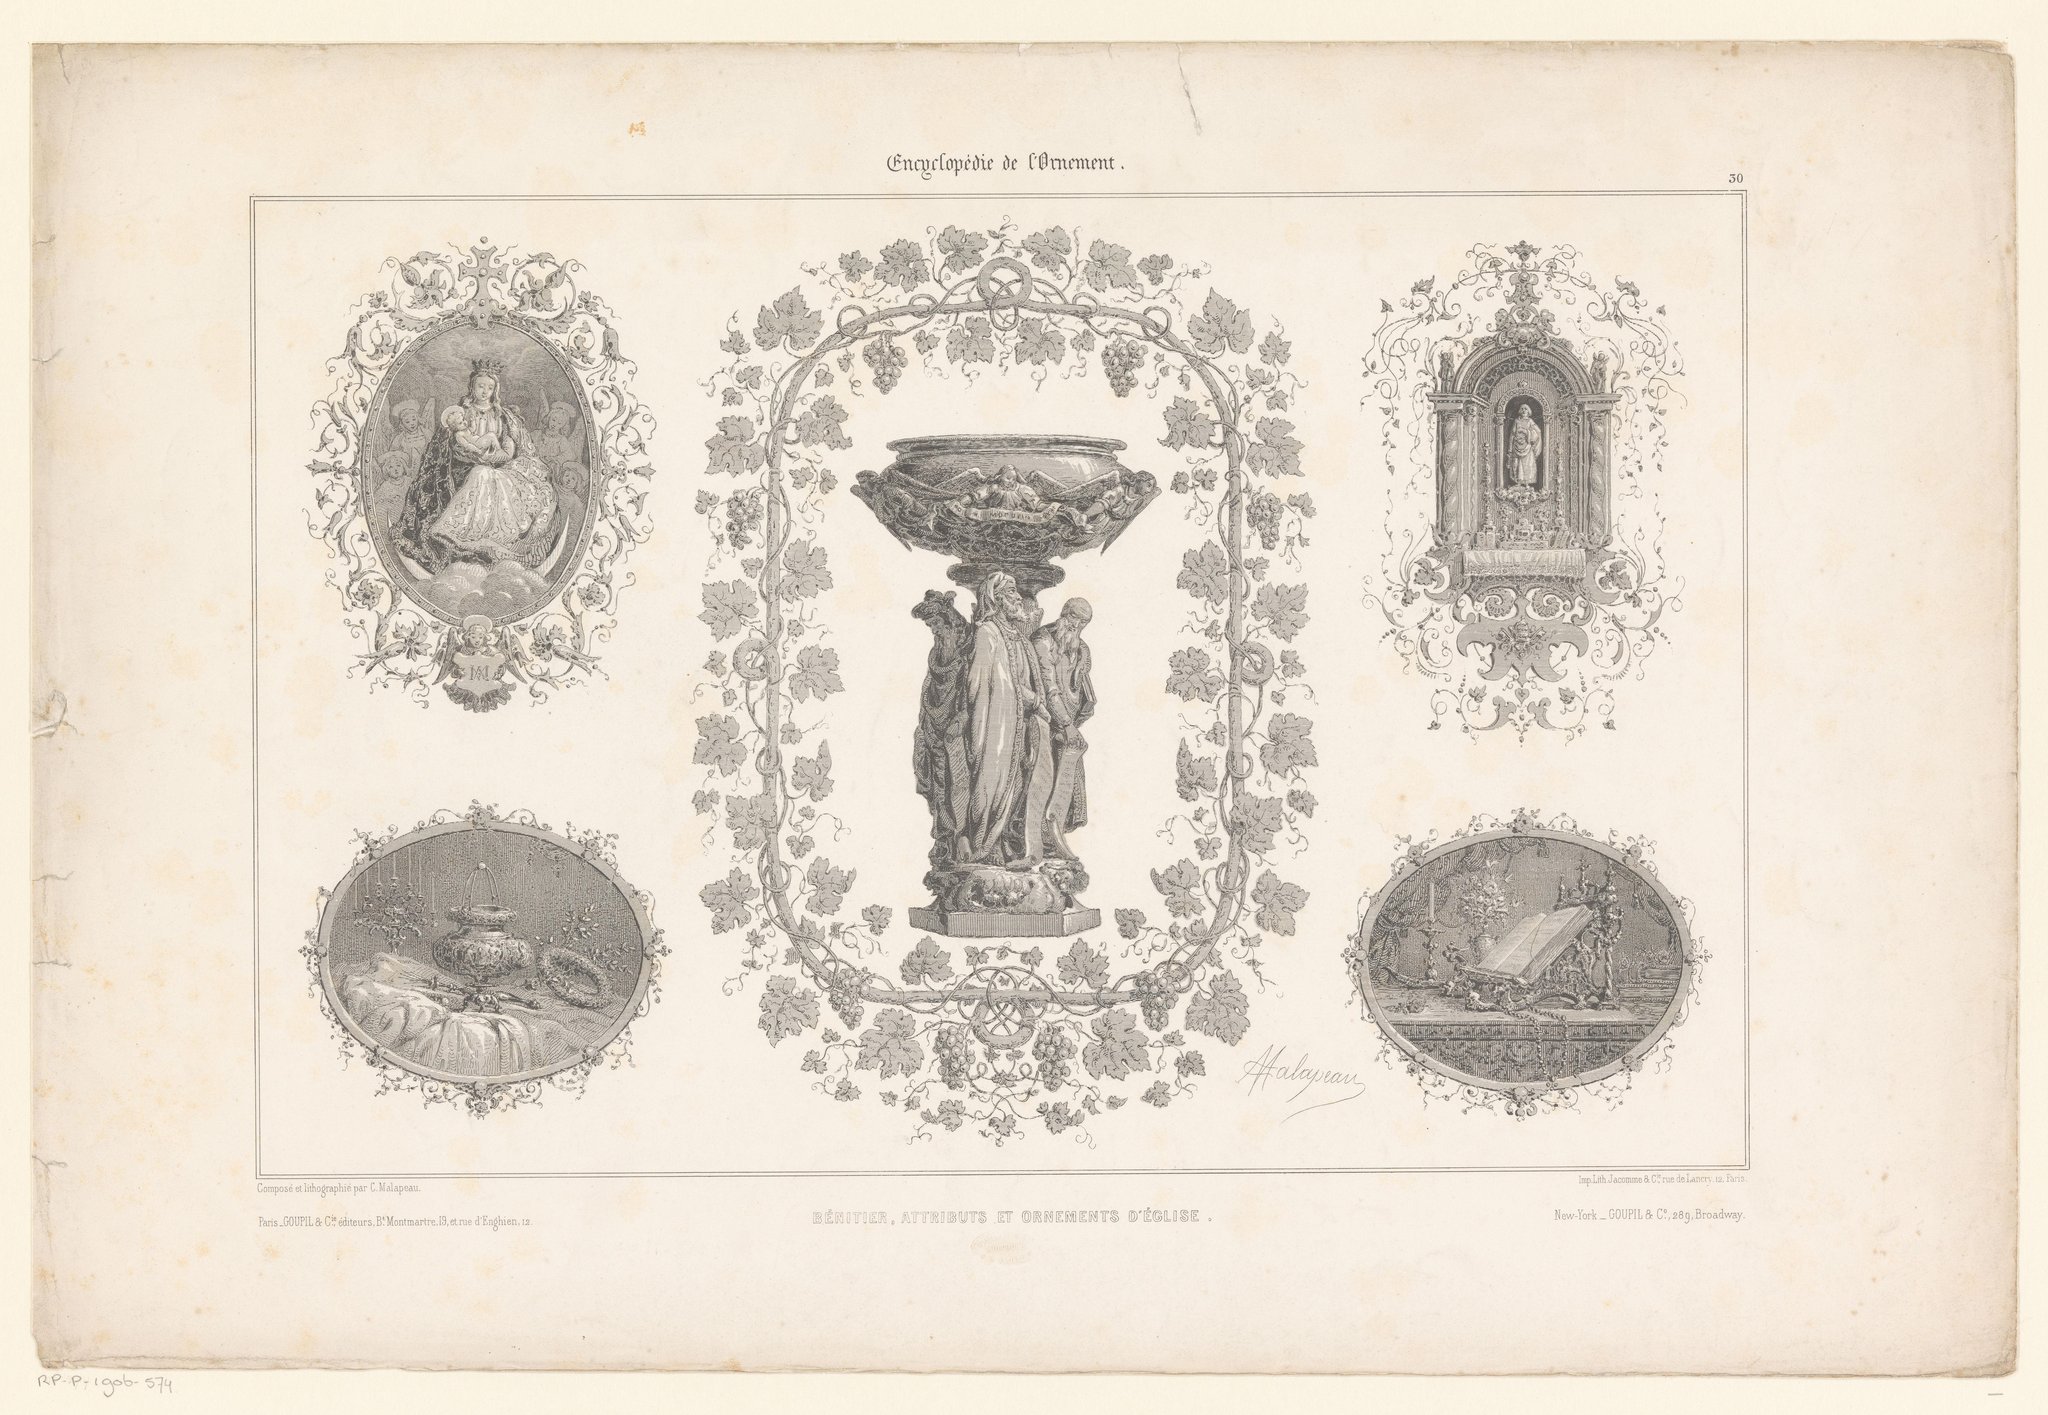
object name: print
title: Bénitier, Attributs Et Ornements D'Église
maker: claude nicolas malapeau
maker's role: print maker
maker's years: 1755-1803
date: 1850-1860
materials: paper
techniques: lithograph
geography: paris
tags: (liturgical) equipment of church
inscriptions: collector's mark: Lugt 2228, check stamp: ‘Goupil, Vibert & C / Editeurs / A Paris’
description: Vijf kerkelijke attributen in geornamenteerde omlijstingen. Links boven een Madonna-afbeelding. Links onder een vat en een zevenarmige kandelaar. In het midden een wijwatervat gedragen door staande figuren. Rechts boven een tabernakel. Rechts onder een missaal op een standaard.